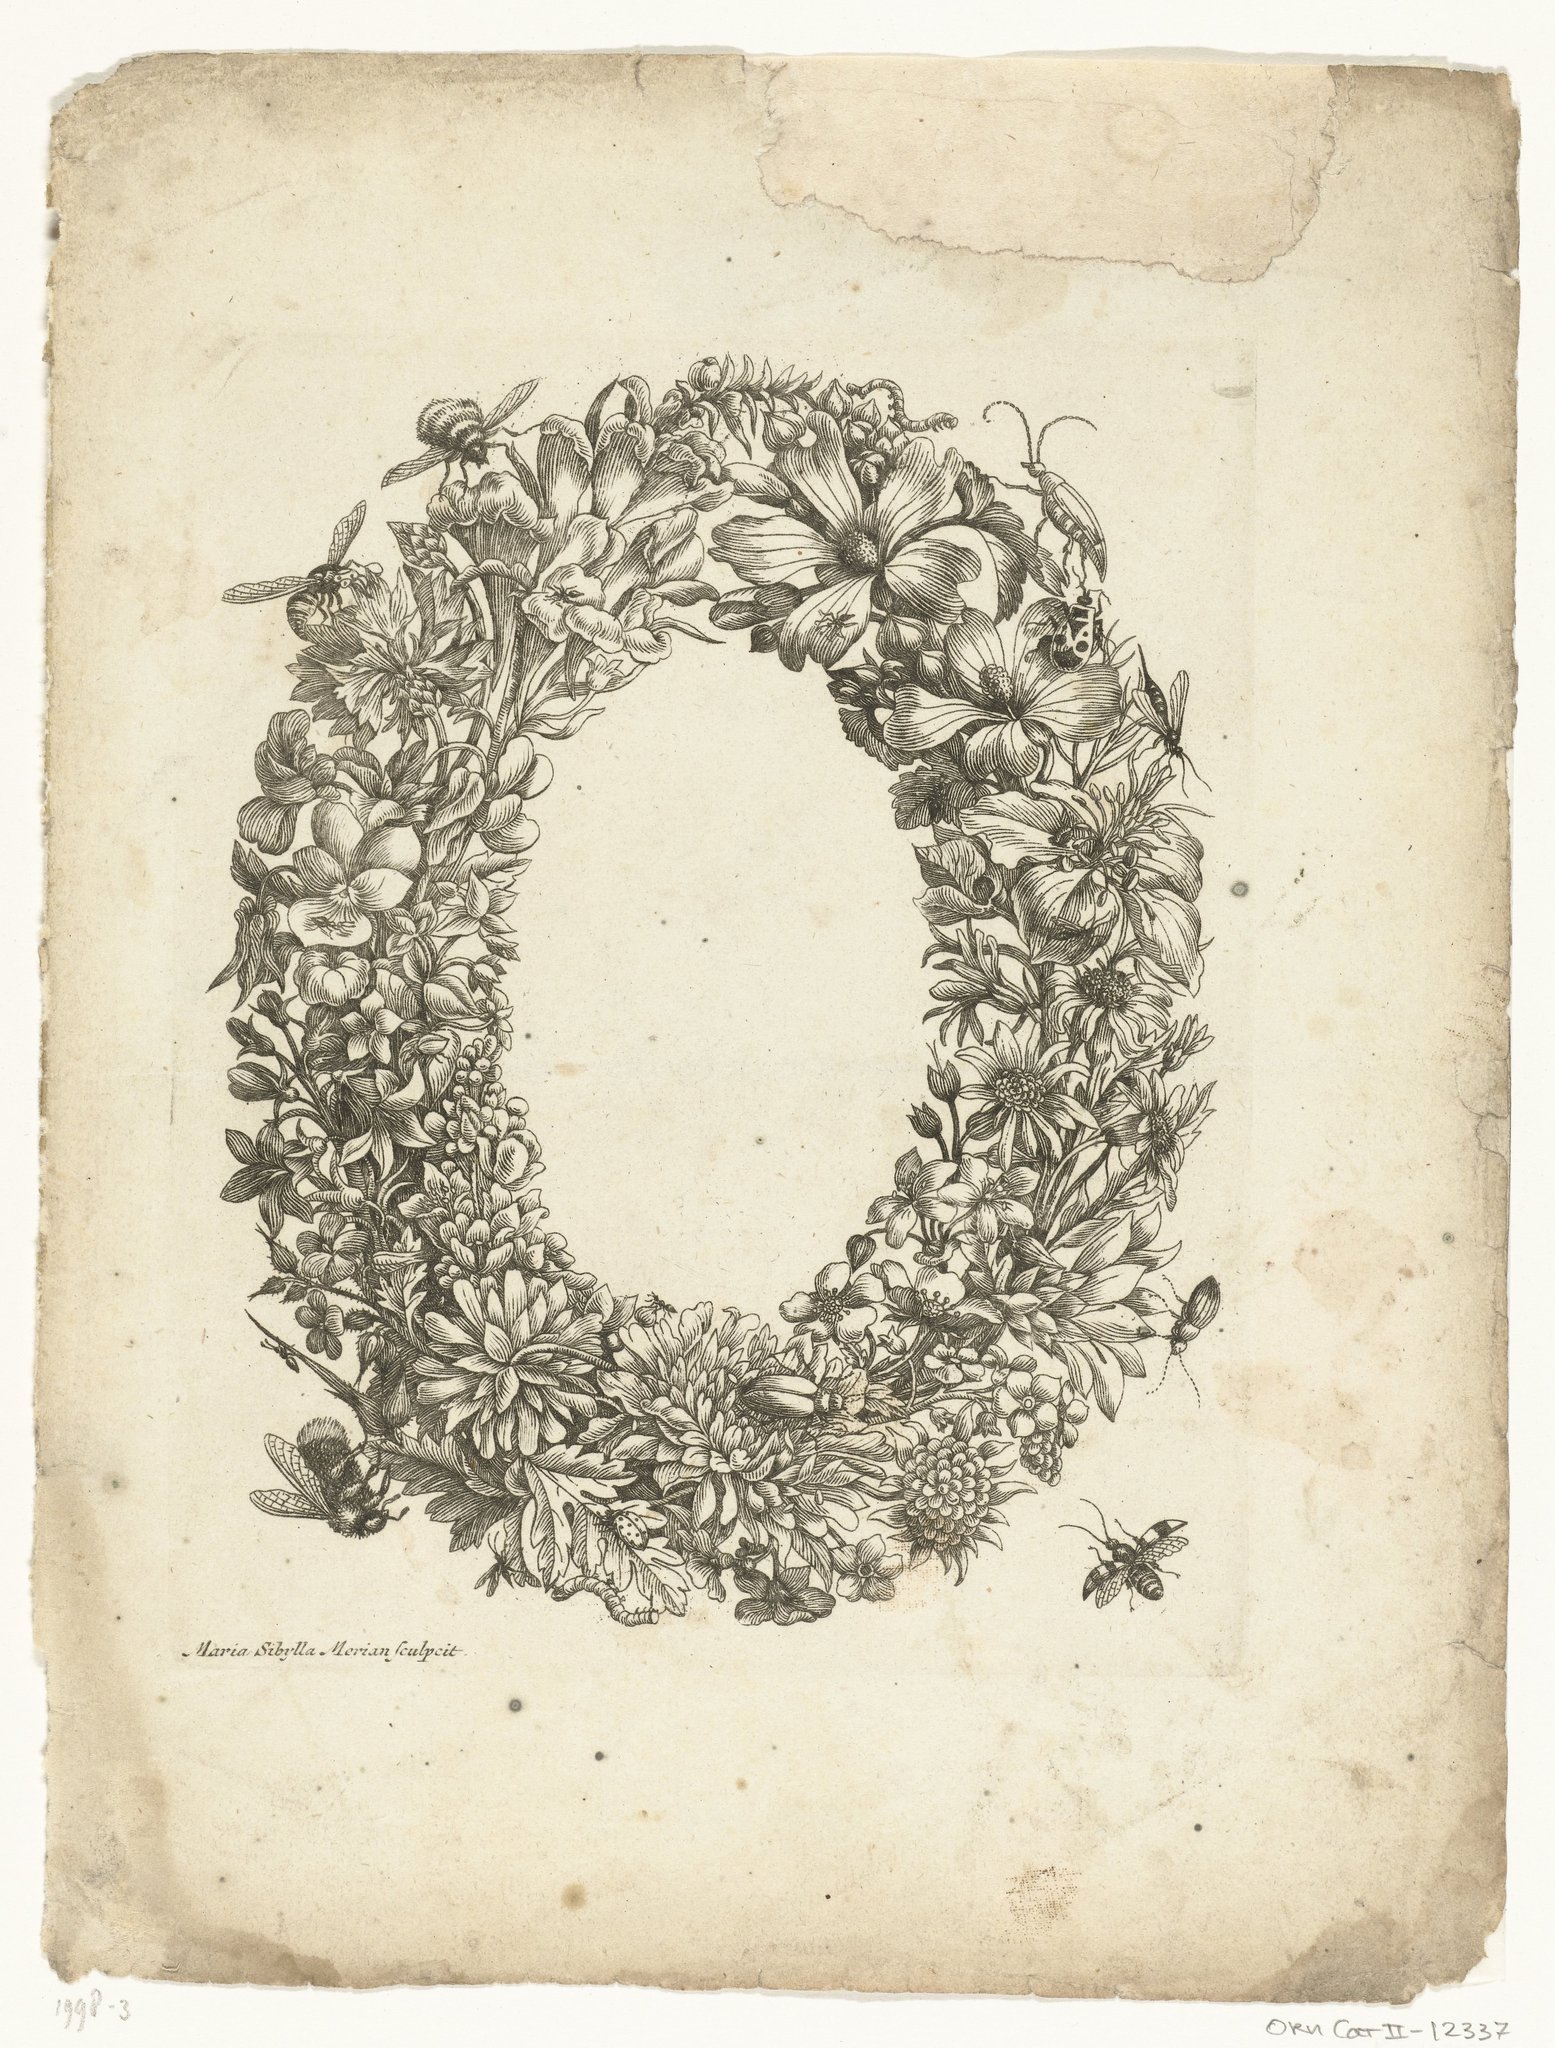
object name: ornament print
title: Bloemenrand met insecten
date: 1657-1717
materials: paper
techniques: etching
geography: germany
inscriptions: signature and date: ‘l.o.: Maria Sibylla Merian Sculpsit’